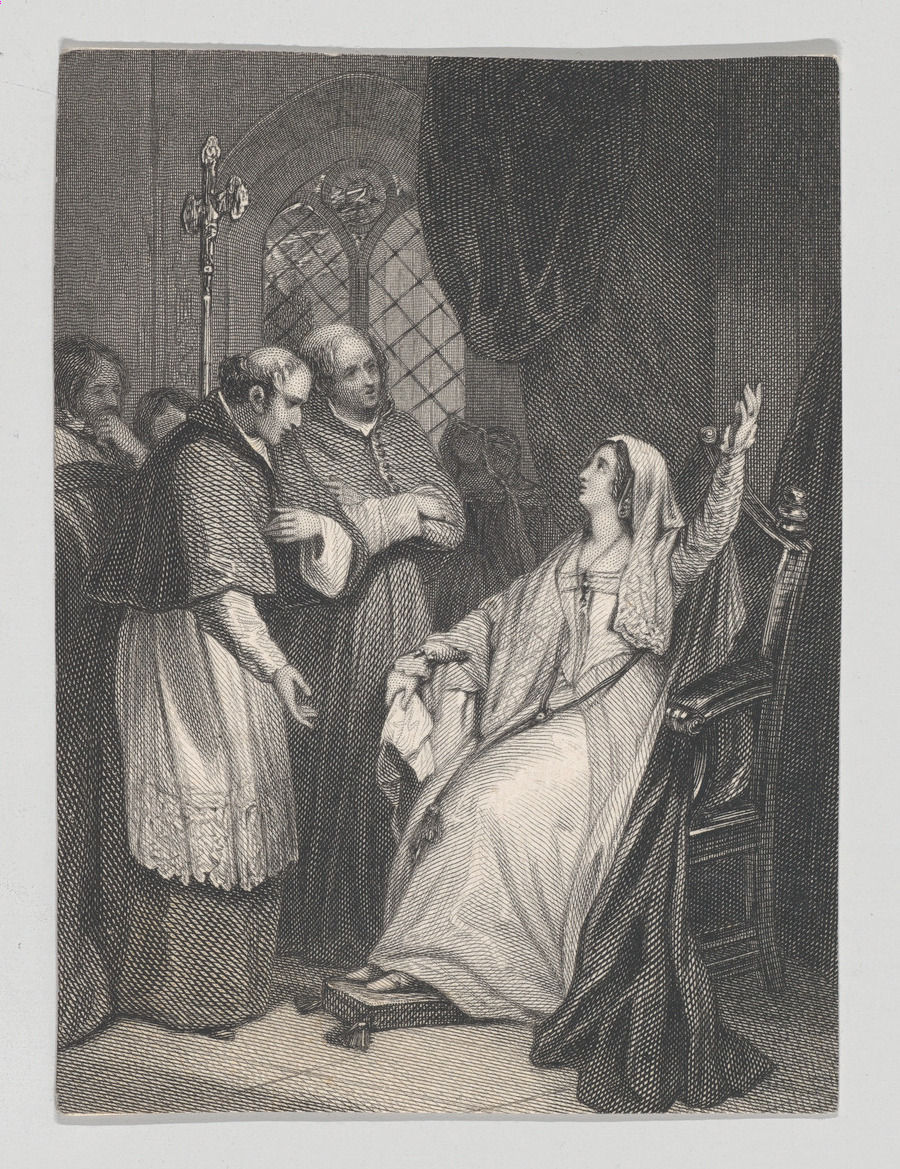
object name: print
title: Catherine of Aragon and Cardinal Wolsey (Shakespeare, King Henry VIII, Act 3, Scene 1)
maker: edward j. potbury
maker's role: engraver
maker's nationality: british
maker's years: 1795-1885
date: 1825-1840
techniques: engraving, etching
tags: queens,shakespeare,men